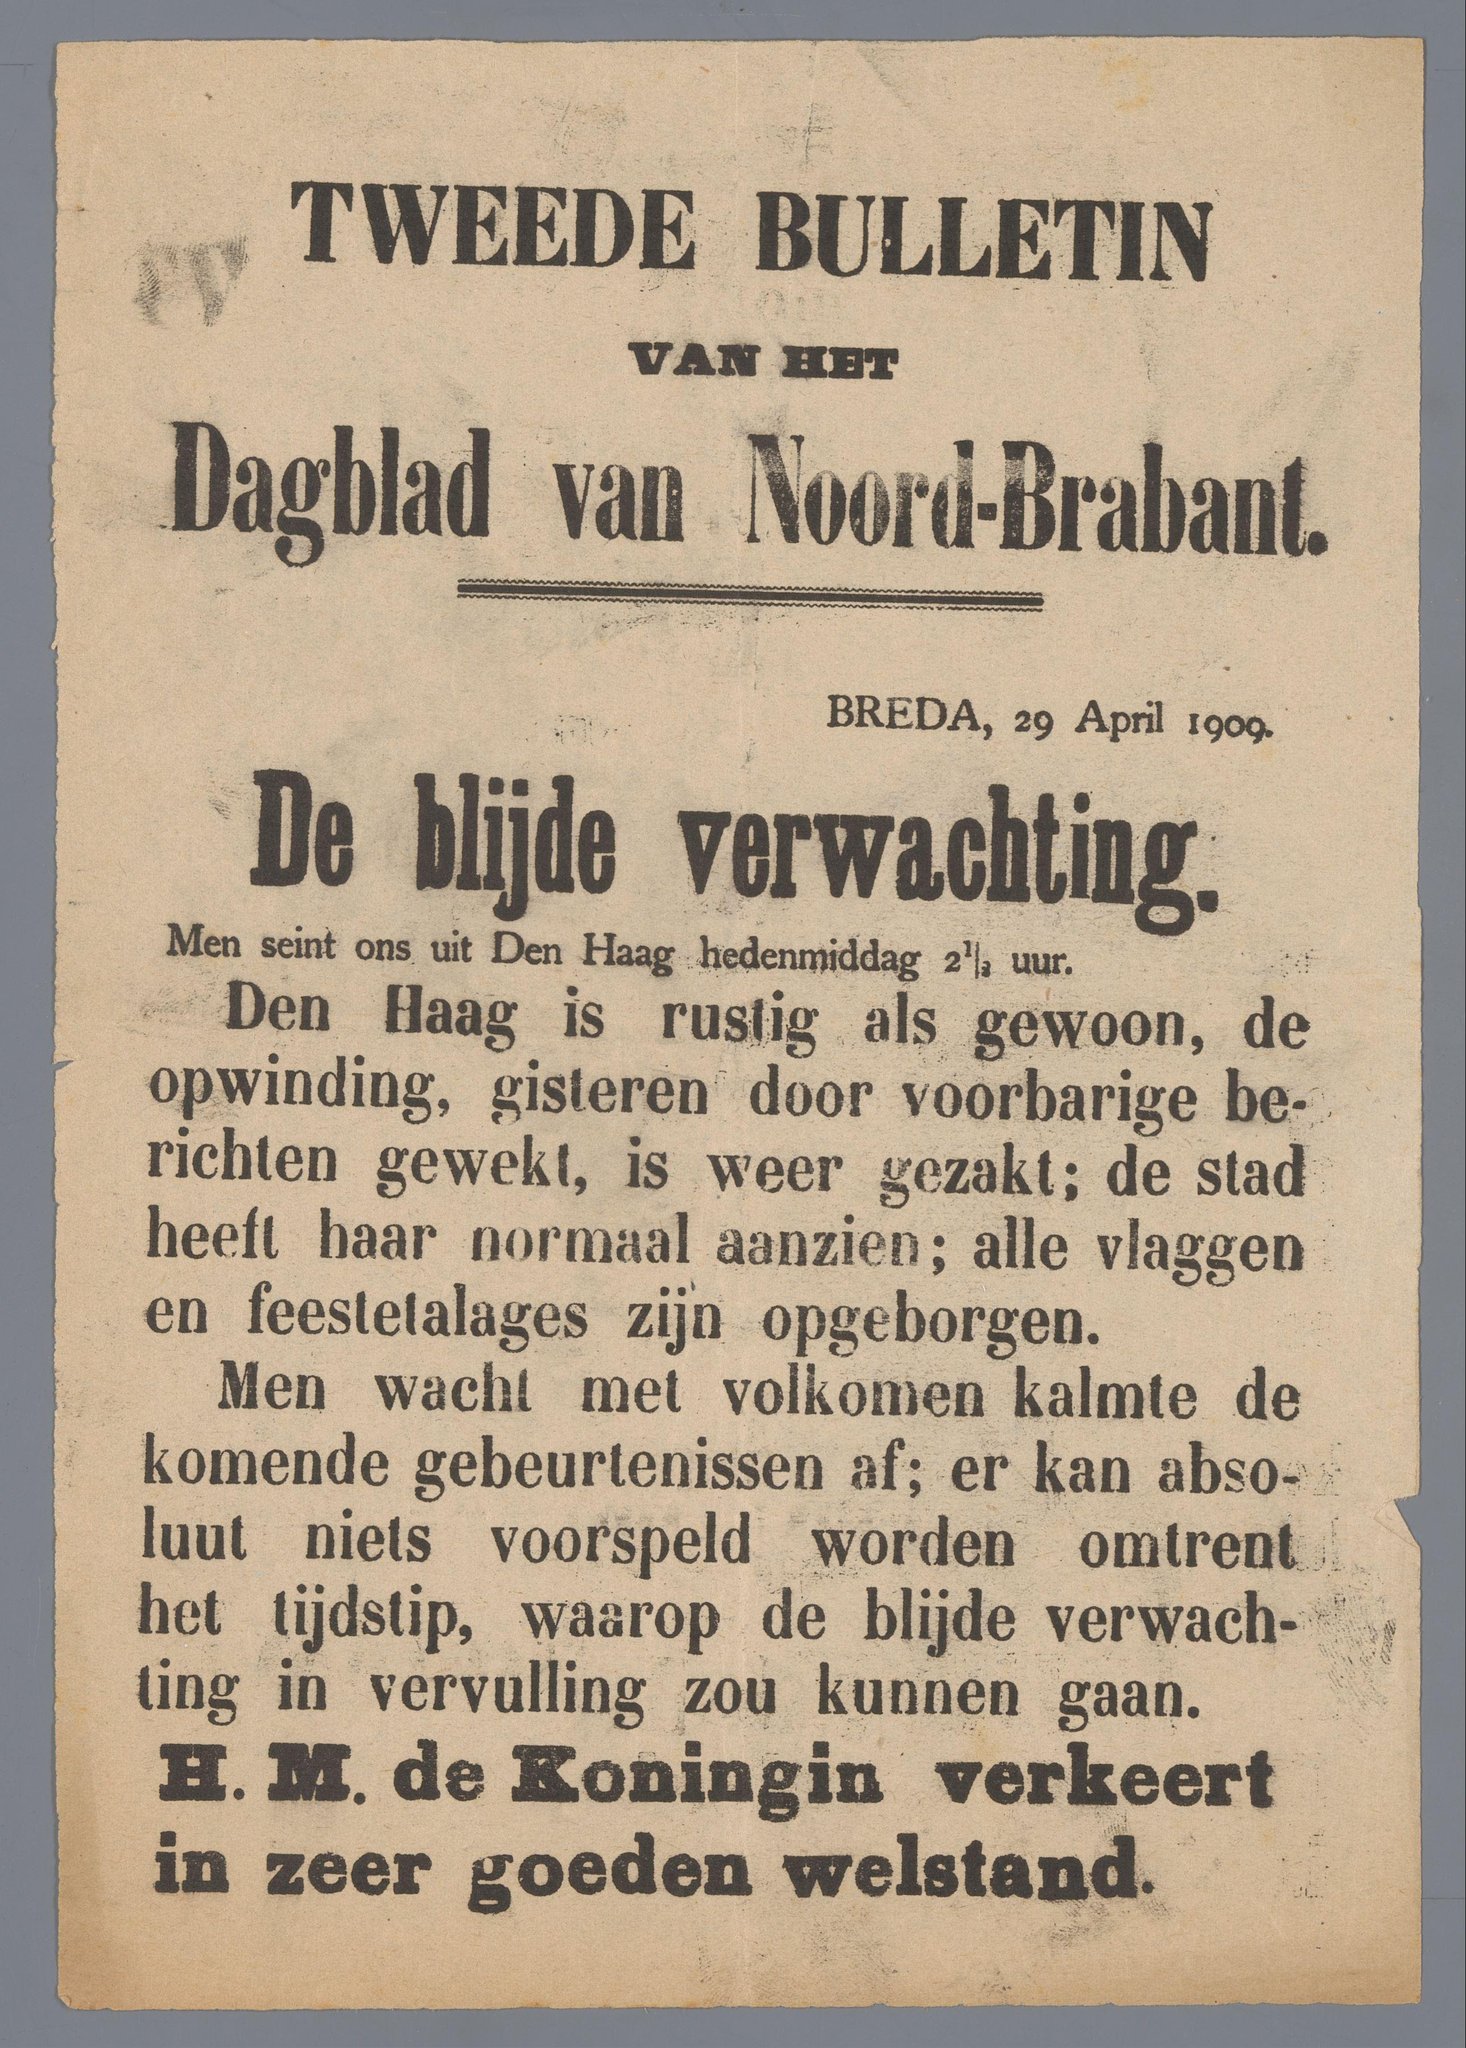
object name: newspaper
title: Bulletin van het "Dagblad van Noord-Brabant"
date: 1909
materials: paper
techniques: printing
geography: breda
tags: the hague, juliana of the netherlands, netherlands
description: Krant. Bulletin van het "Dagblad van Noord-Brabant" (abusievelijk gedateerd op 29 april 1908) éénzijdig bedrukt blad papier over de geboorte van prinses Juliana, 30 april 1909.